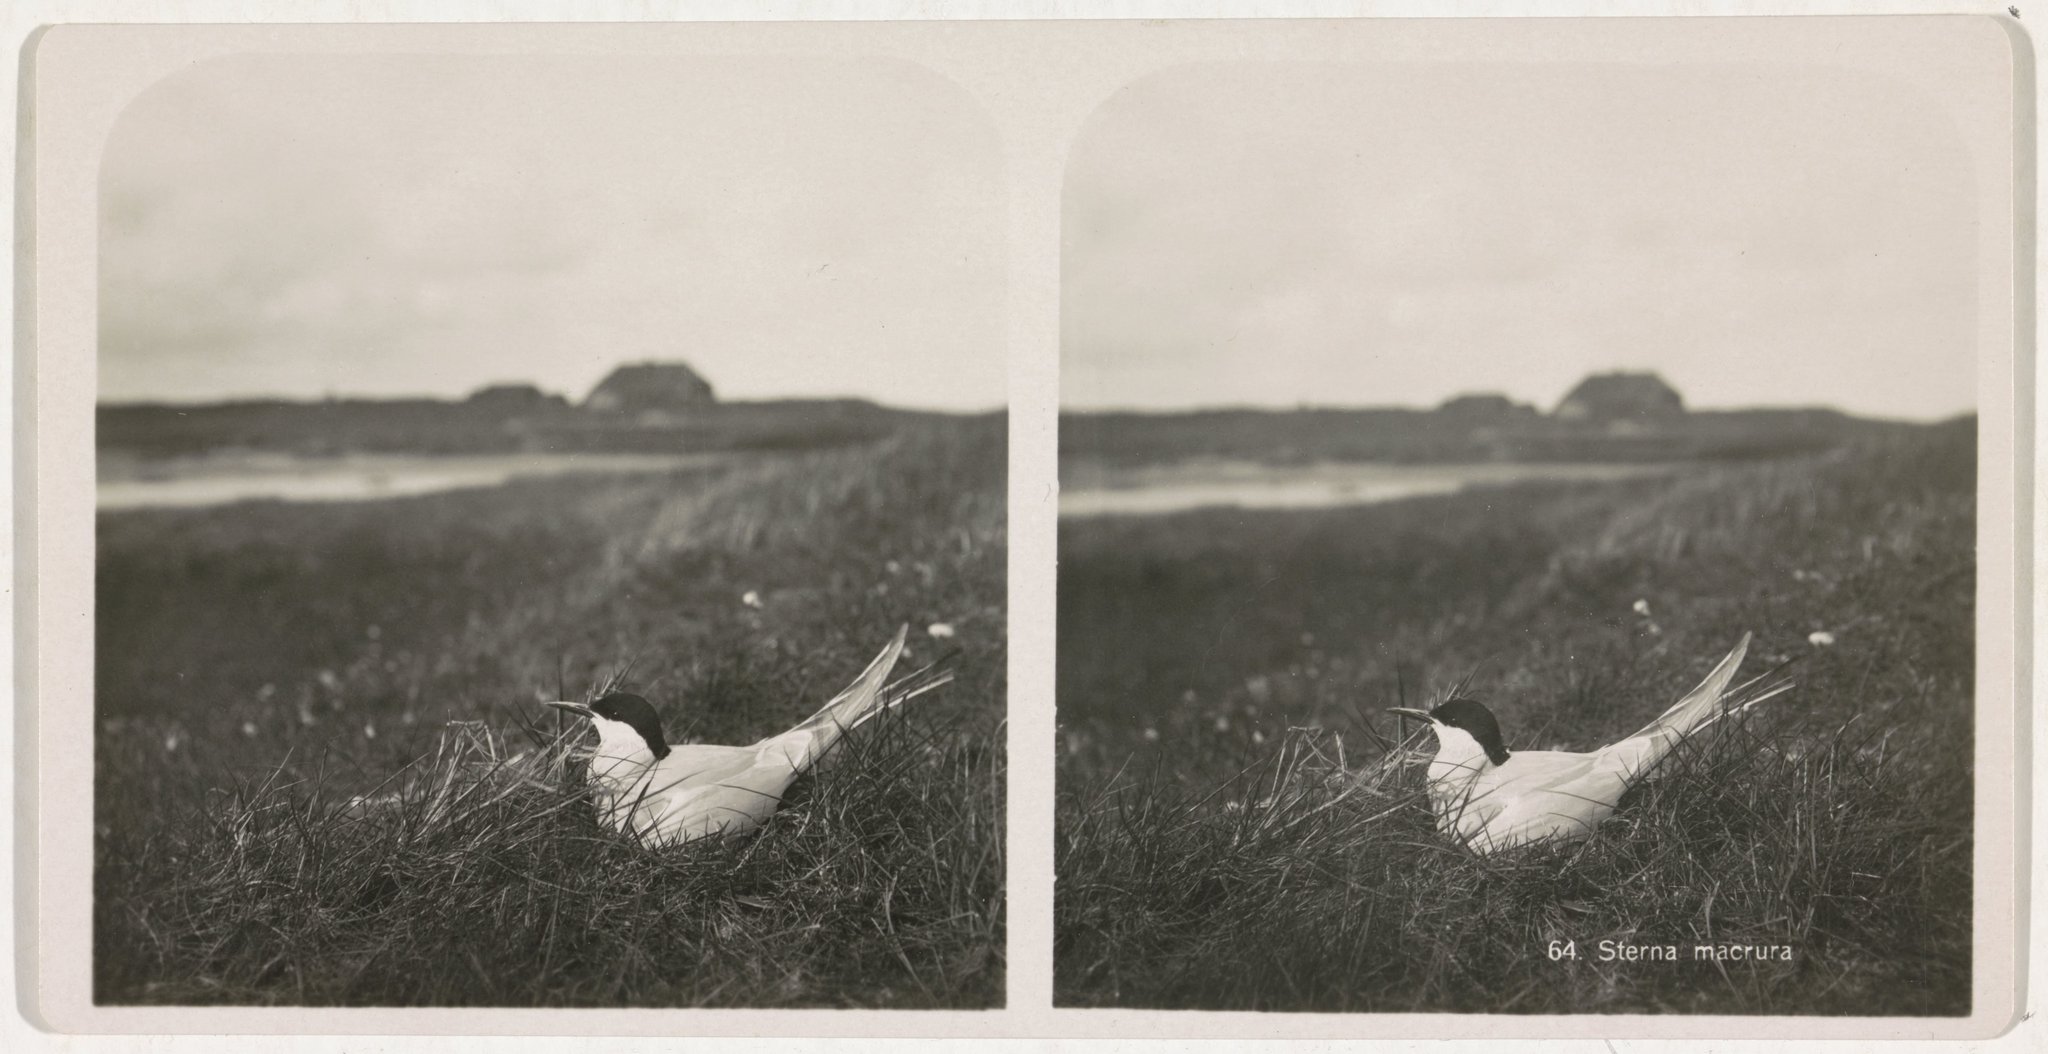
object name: photograph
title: Onze vogels in 't wild. / Zeevogels / Sterntjes en Meeuwen.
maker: adolphe burdet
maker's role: fotograaf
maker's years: 1860-1940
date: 1870-1940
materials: photographic support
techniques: gelatin silver print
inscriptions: label: ‘Zee Zwaluw.’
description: De foto maakt deel uit van een serie van 12 stereofoto's, bewaard in het originele mapje. De foto's tonen zeevogels in natuurgebied De Bol op Texel.